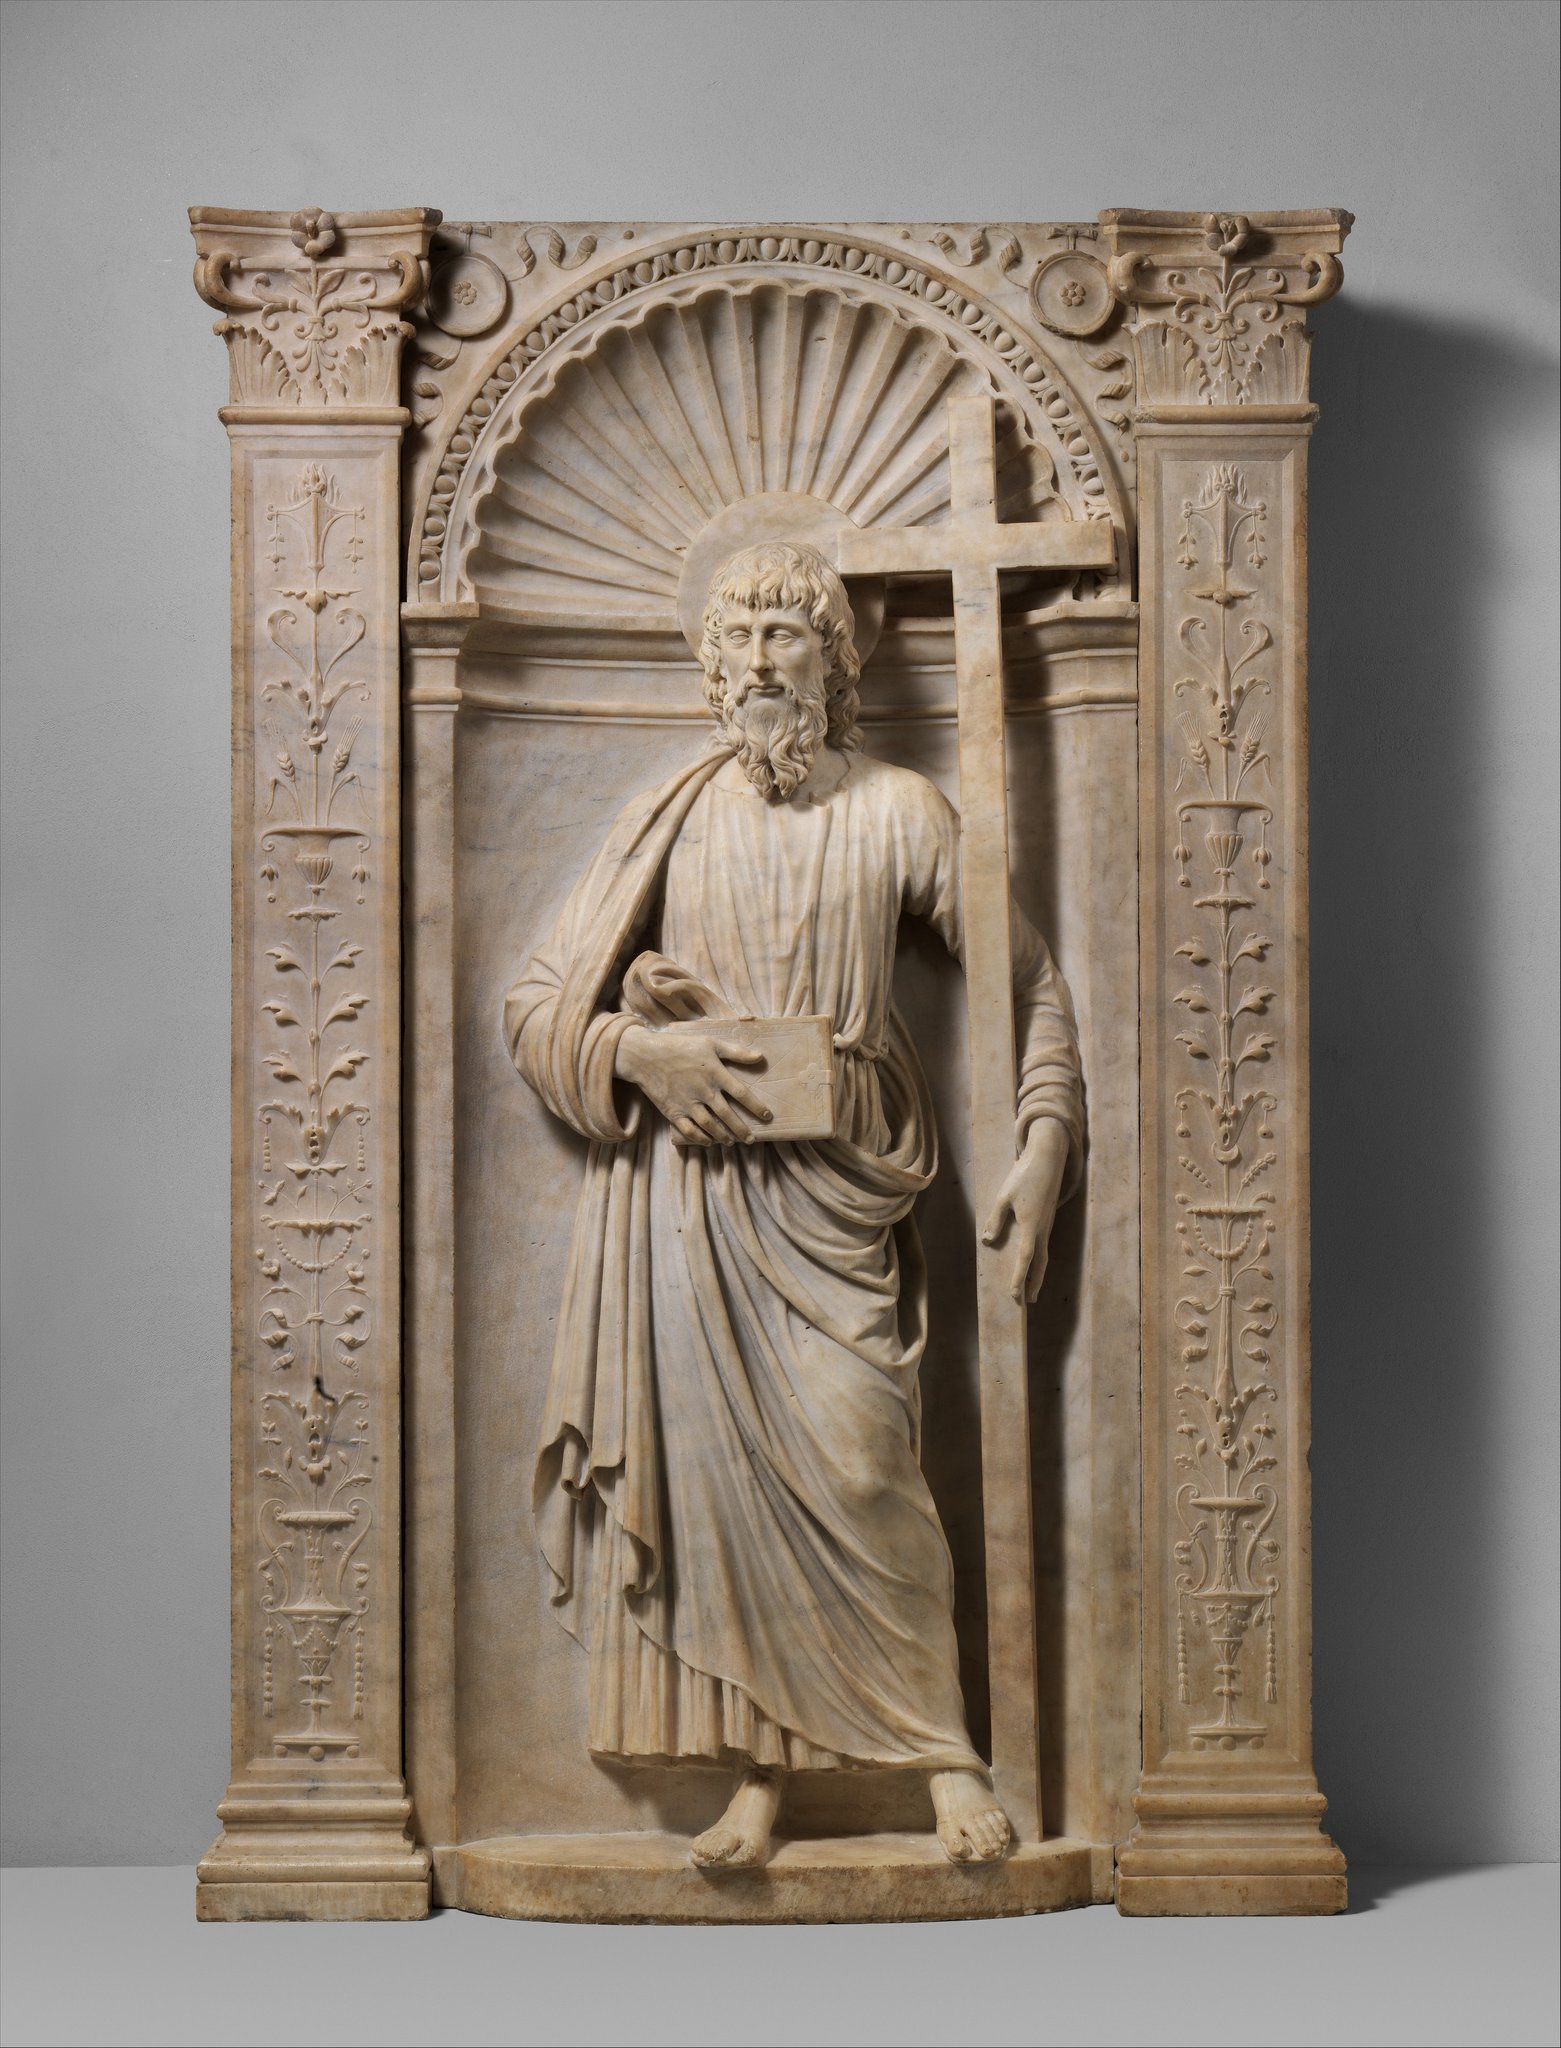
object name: relief and pilaster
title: Saint Andrew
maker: andrea bregno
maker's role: artist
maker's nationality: italian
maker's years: 1418-1503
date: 1491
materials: marble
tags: men,saints